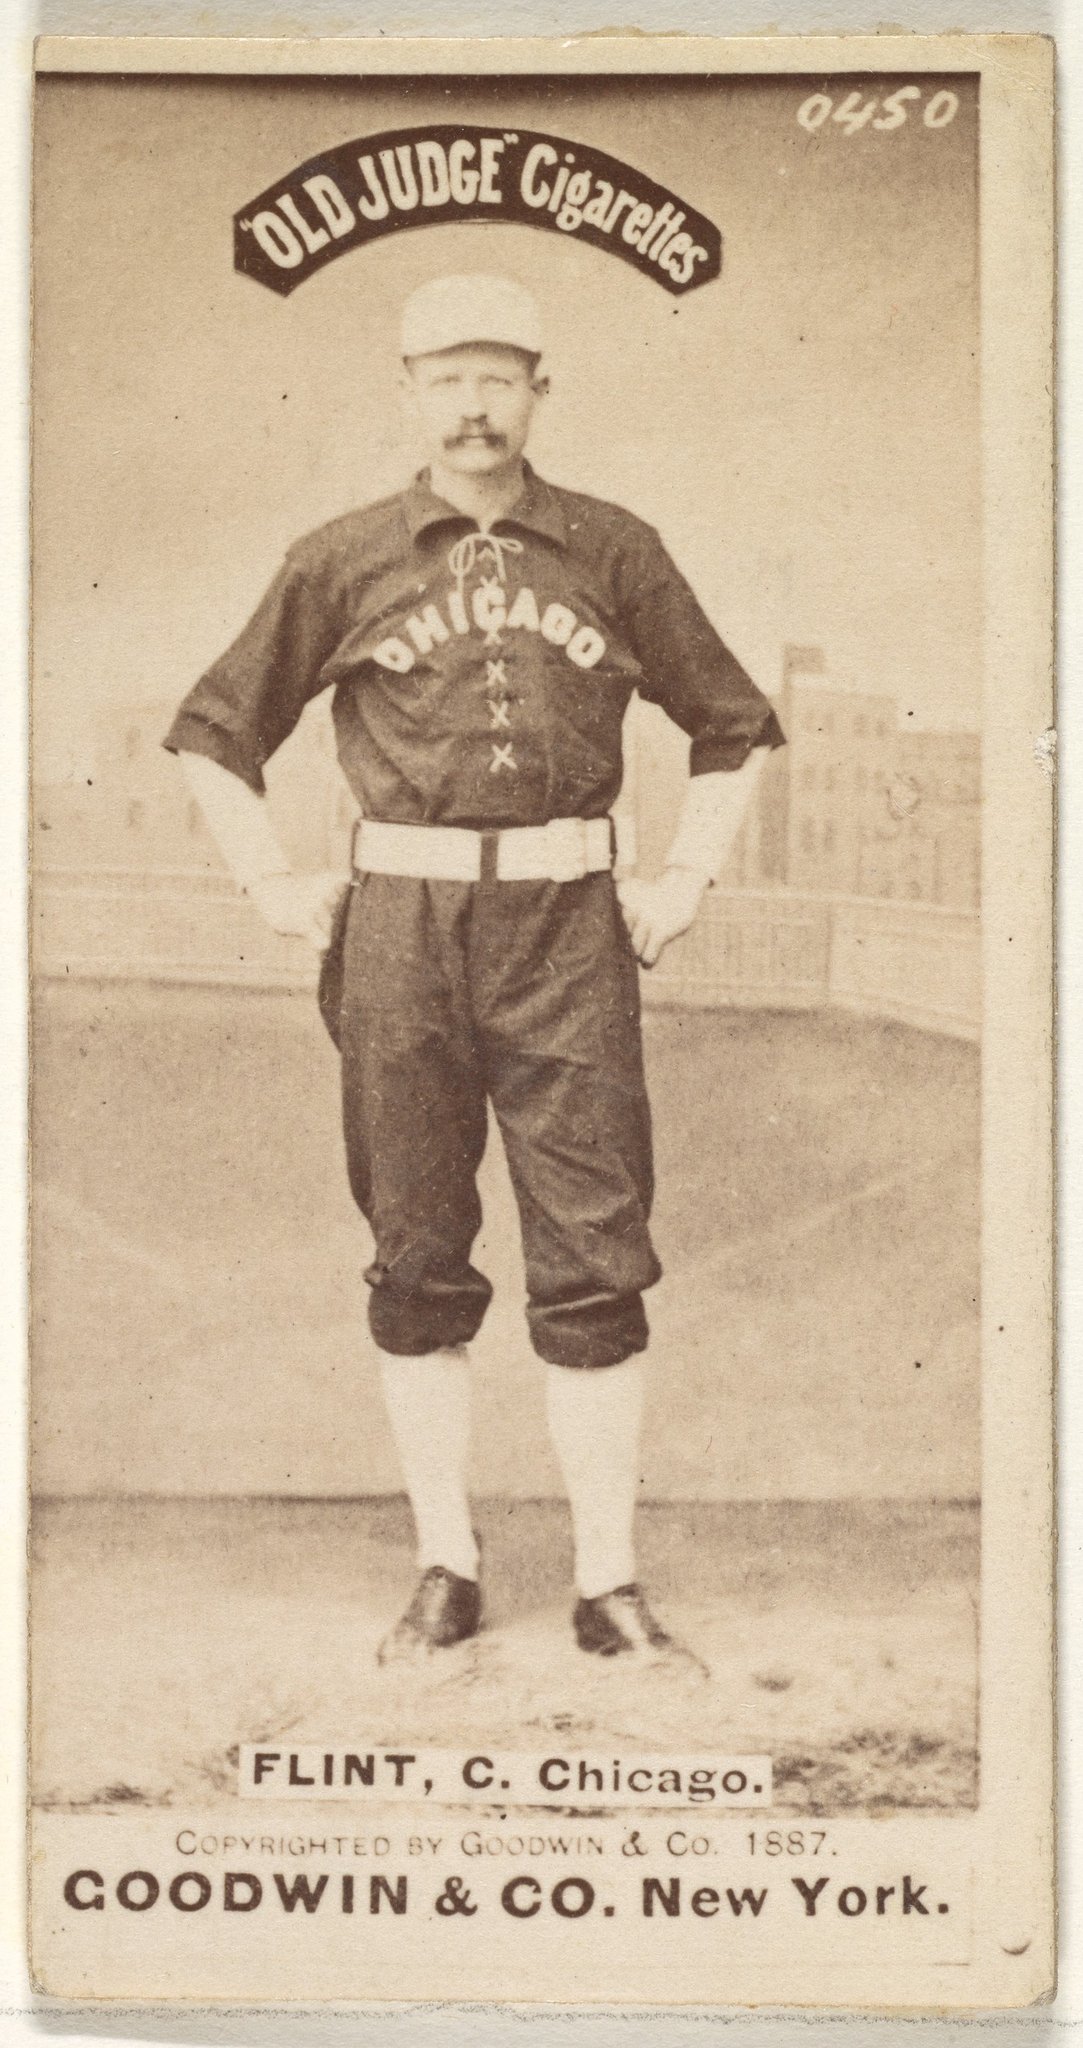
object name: baseball card, photograph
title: Frank Sylvester "Silver" Flint, Catcher, Chicago, from the Old Judge series (N172) for Old Judge Cigarettes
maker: goodwin & company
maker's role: publisher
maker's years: 1850-1950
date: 1887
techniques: albumen silver print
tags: men,portraits,baseball,athletes